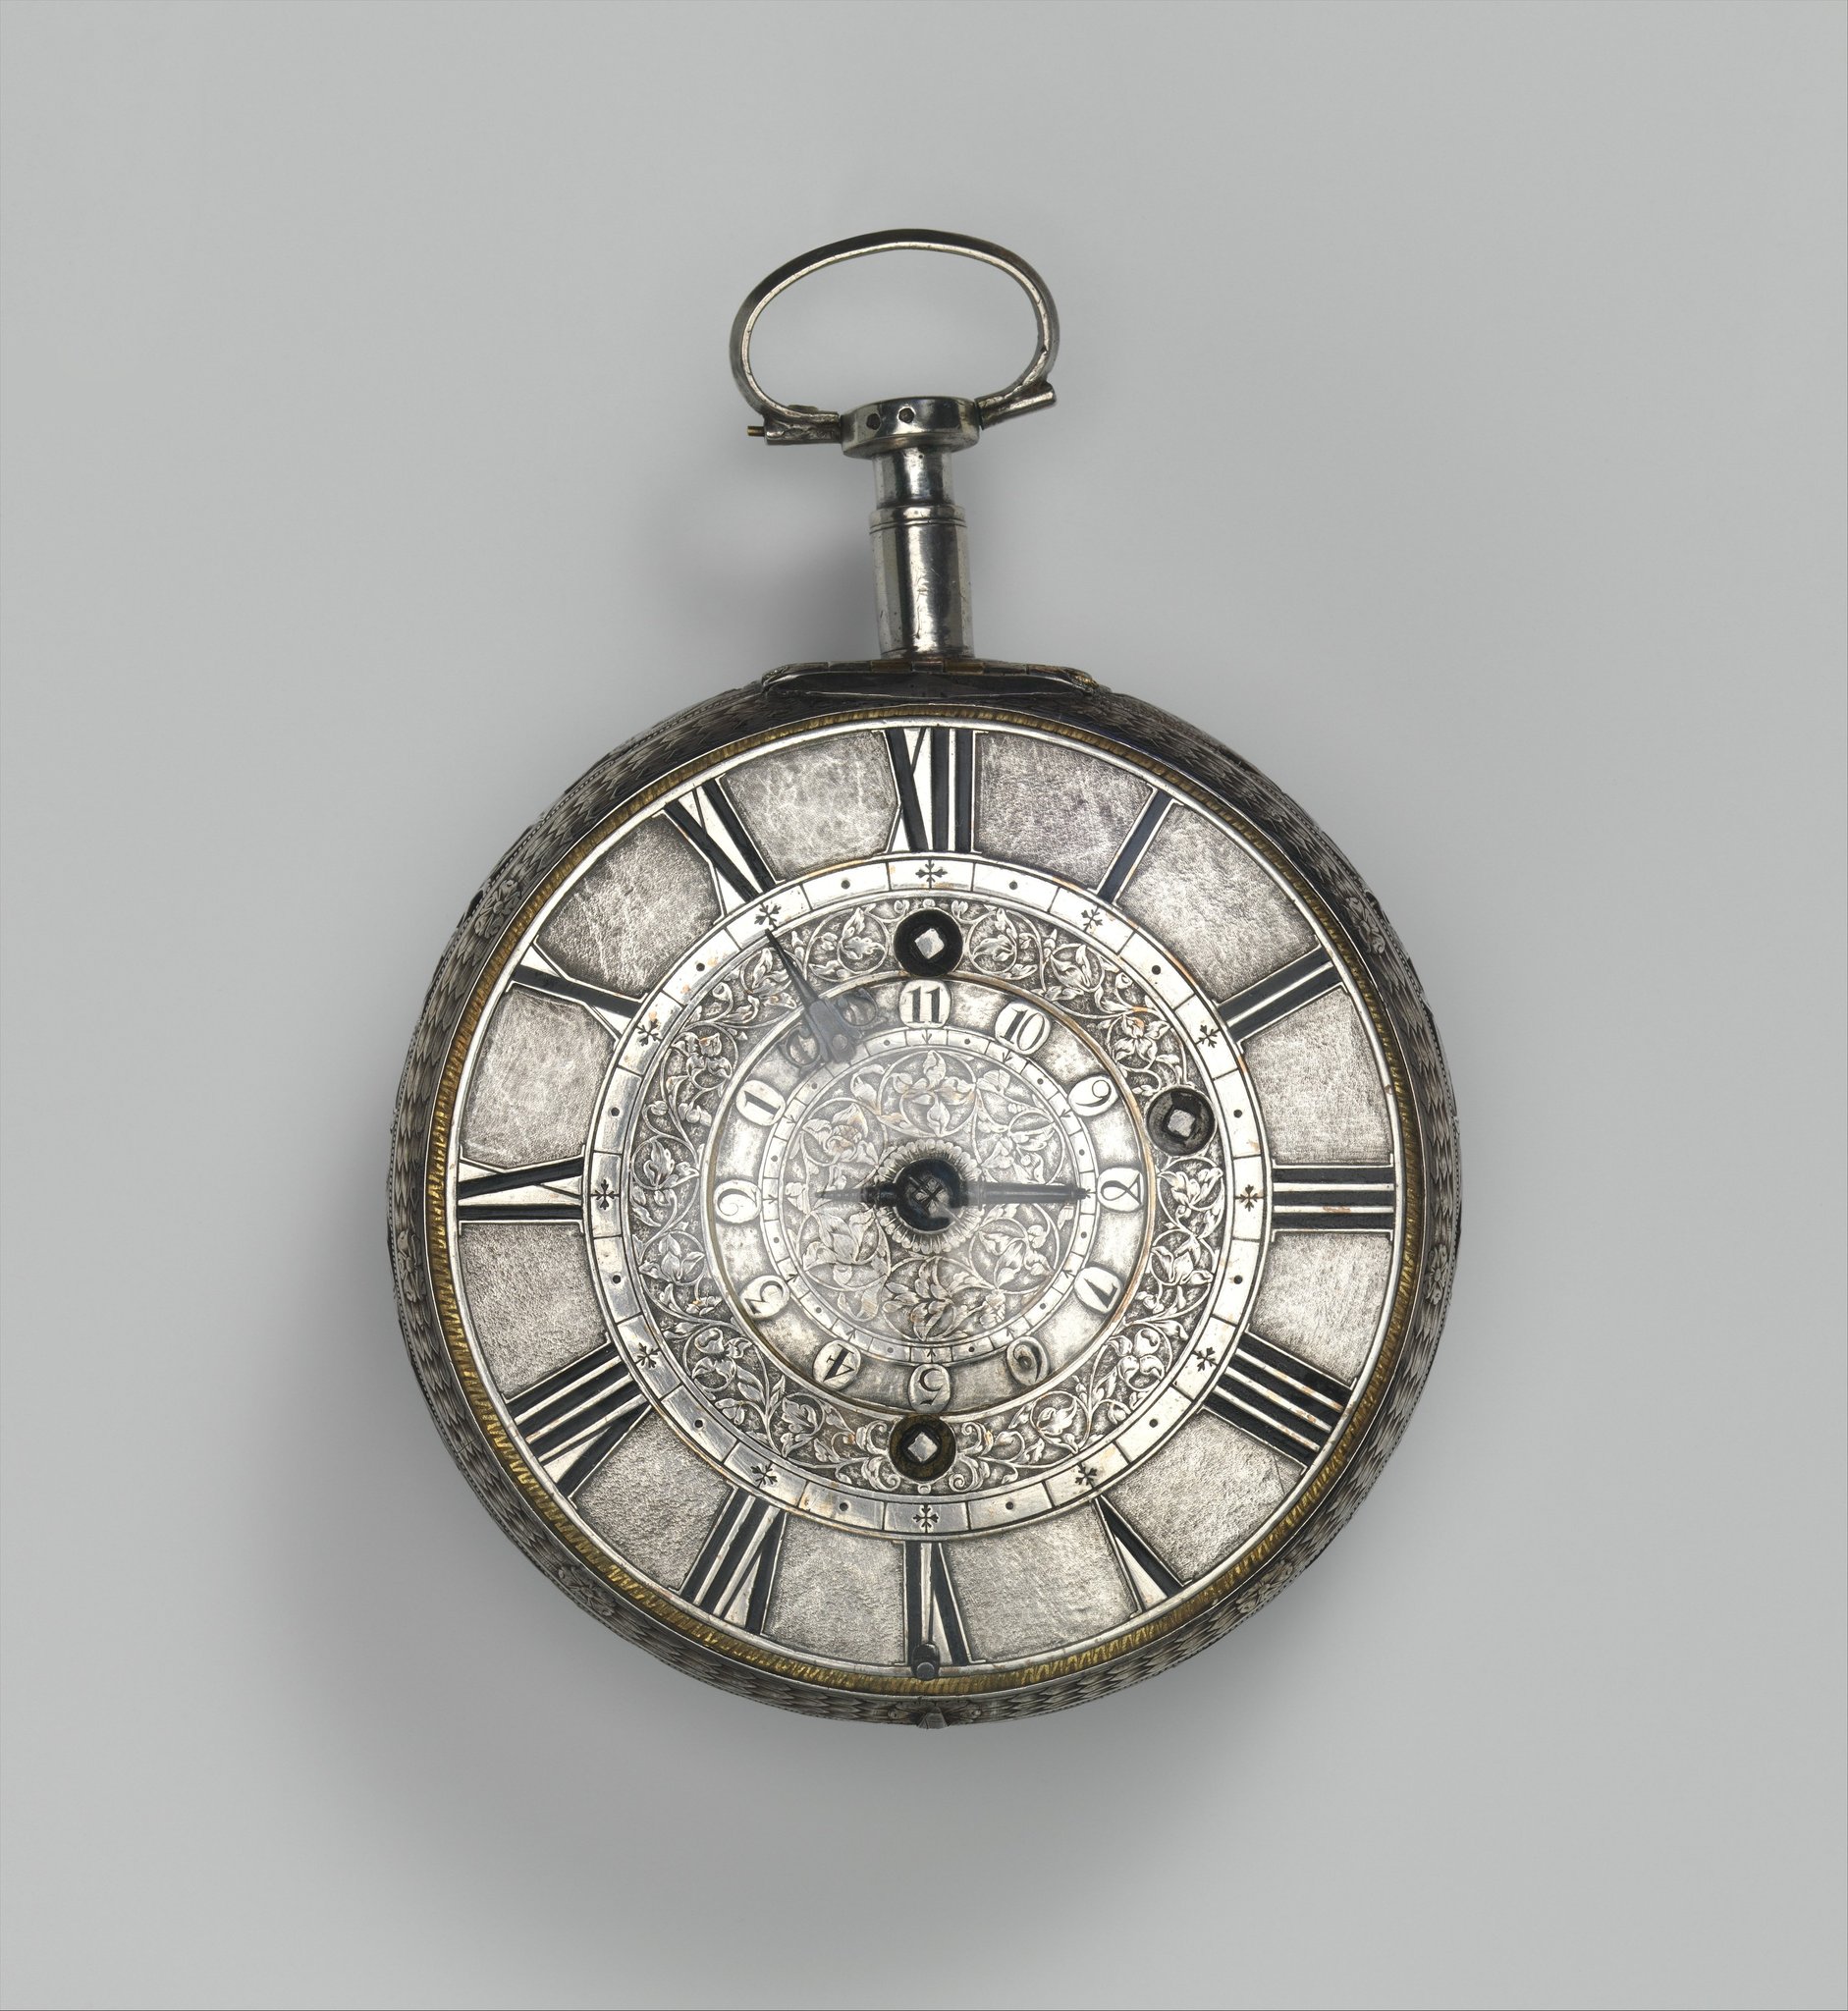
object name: traveling clock watch with alarm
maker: thomas tompion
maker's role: maker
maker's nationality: british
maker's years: 1639-1713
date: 1680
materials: gilt brass, silver, steel